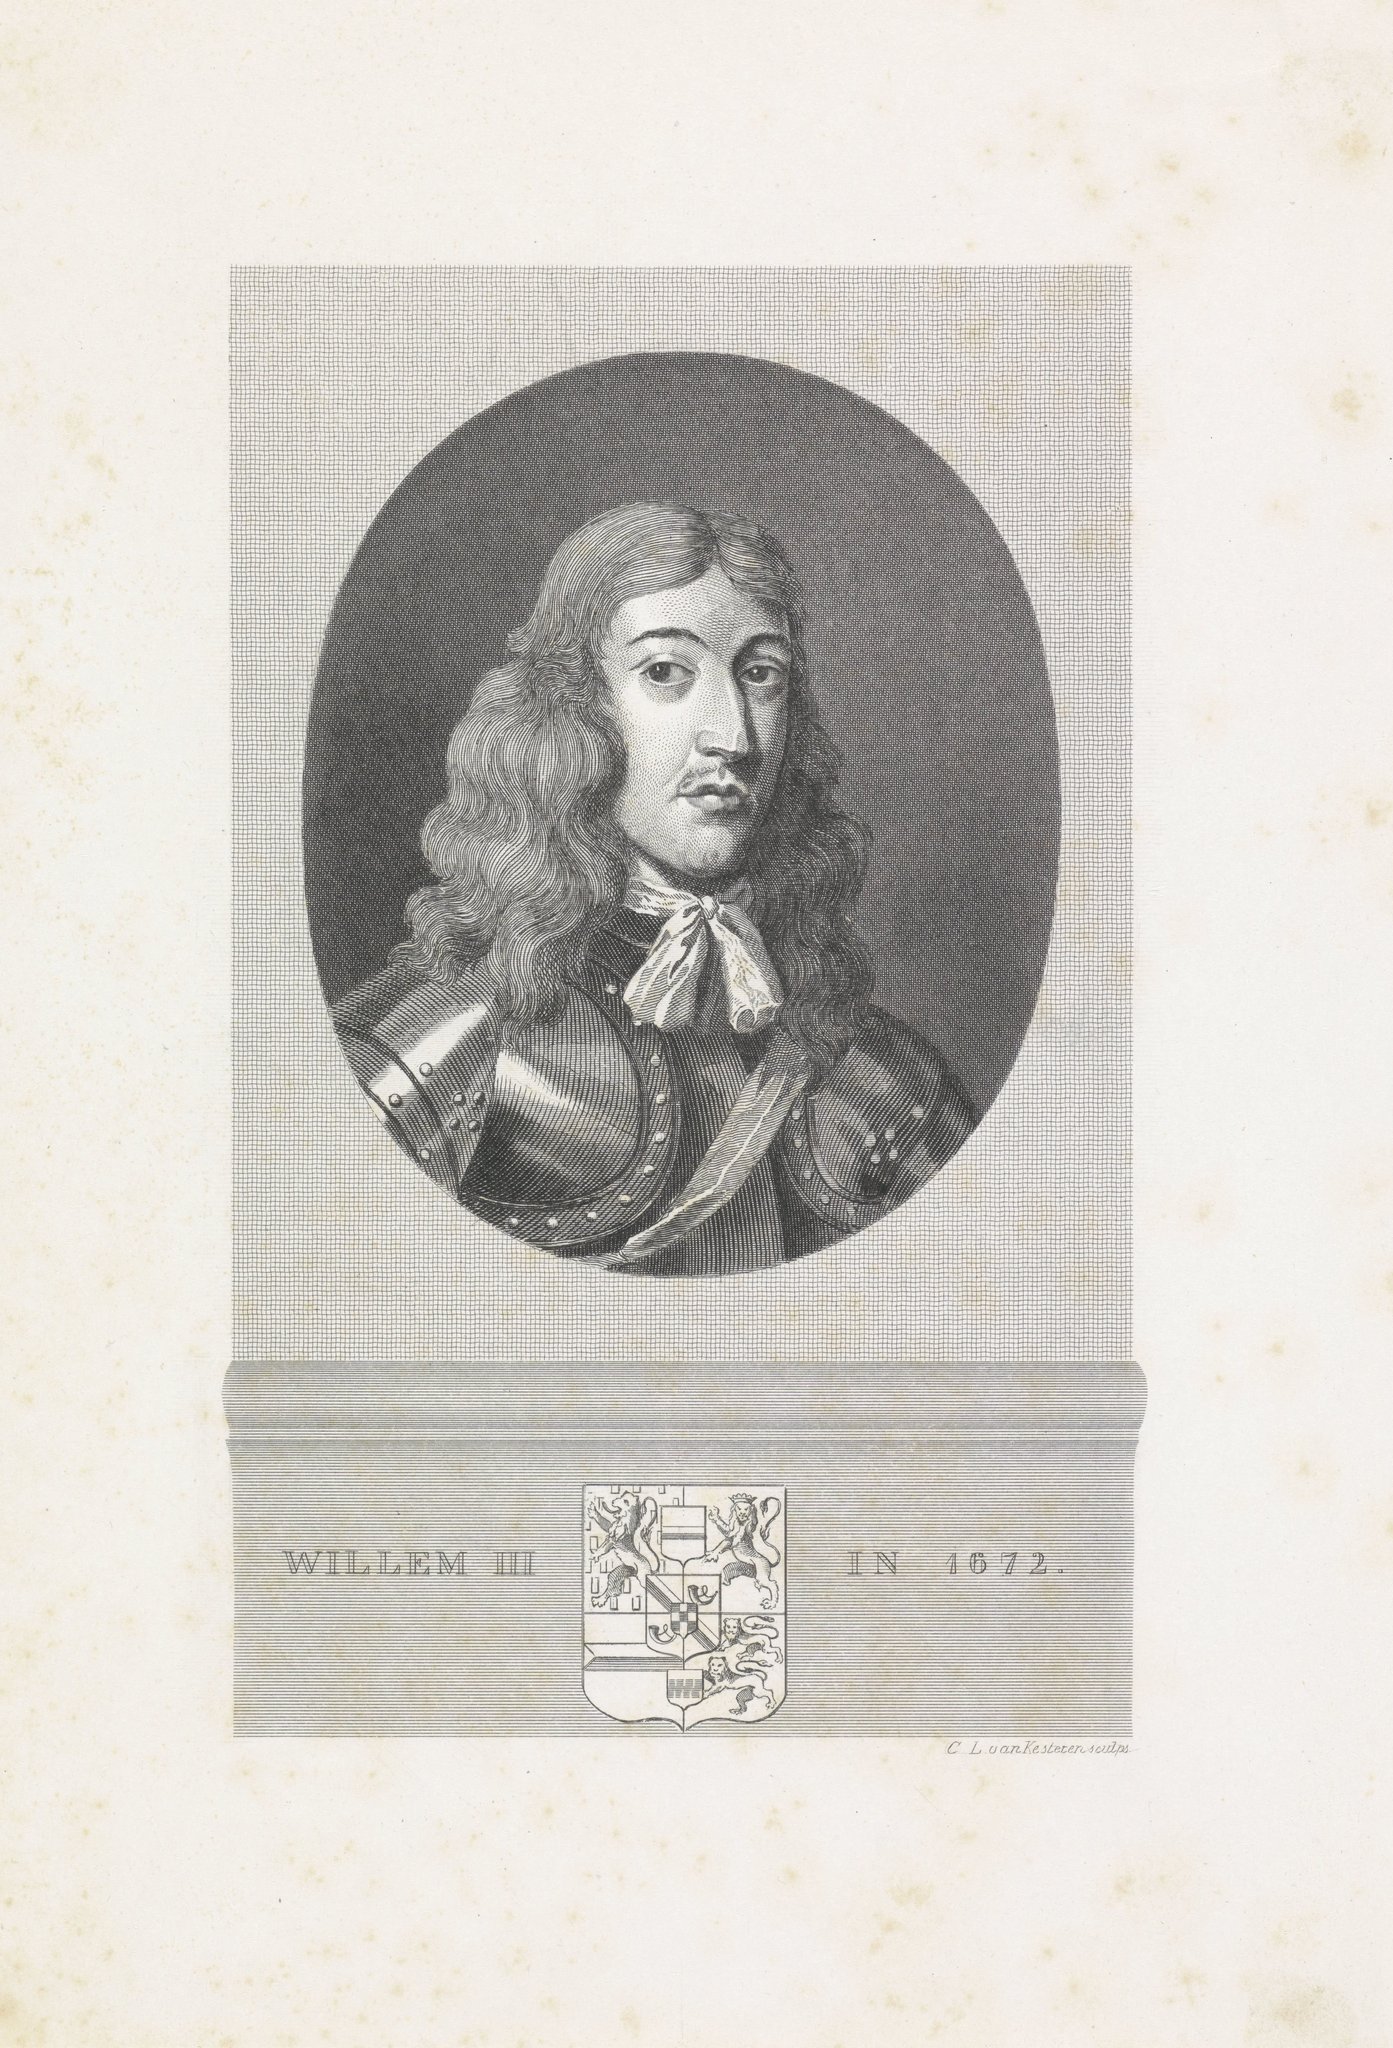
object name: print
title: Portret van Willem III, prins van Oranje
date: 1840-1884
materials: paper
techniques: engraving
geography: amsterdam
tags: the hague, william iii (prince of orange and king of england, scotland, and ireland)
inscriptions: collector's mark: Lugt 2228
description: De hier vermelde titel verwijst naar de hoogst verkregen titel van de geportretteerde, niet per se naar de titel die de geportretteerde op deze voorstelling draagt. Prent uit: Arend, Johannes Pieter. Algemeene geschiedenis des vaderlands van de vroegste tijden tot op heden. Amsterdam: J.F. Schleijer, 1840-1884.